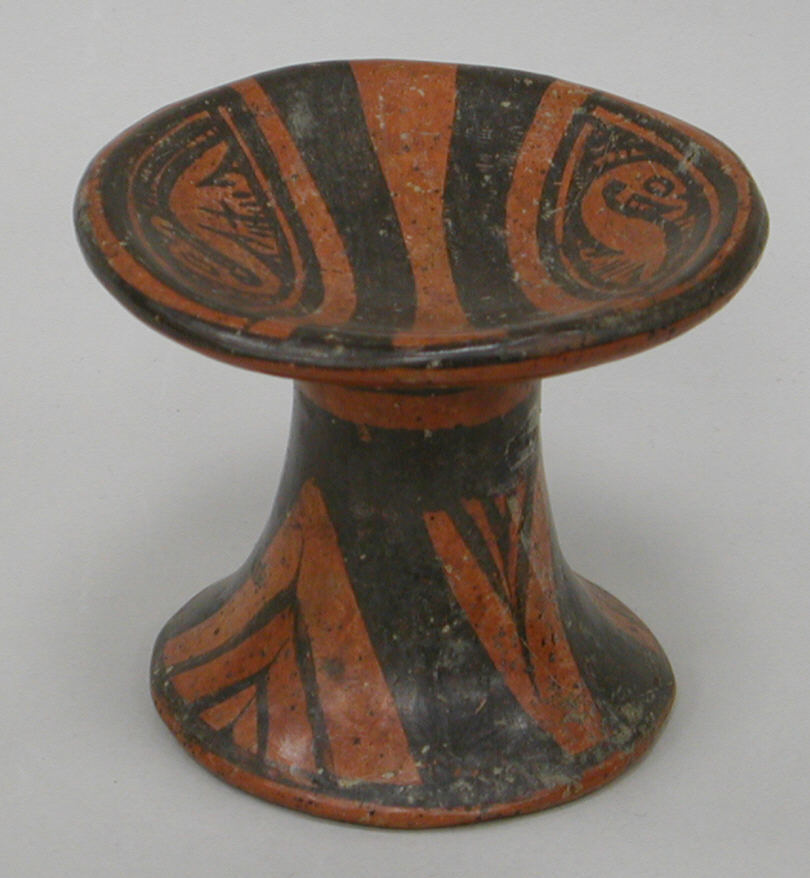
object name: plate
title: Pedestal Plate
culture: coclé, macaracas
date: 701-1200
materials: ceramic, pigment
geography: panama